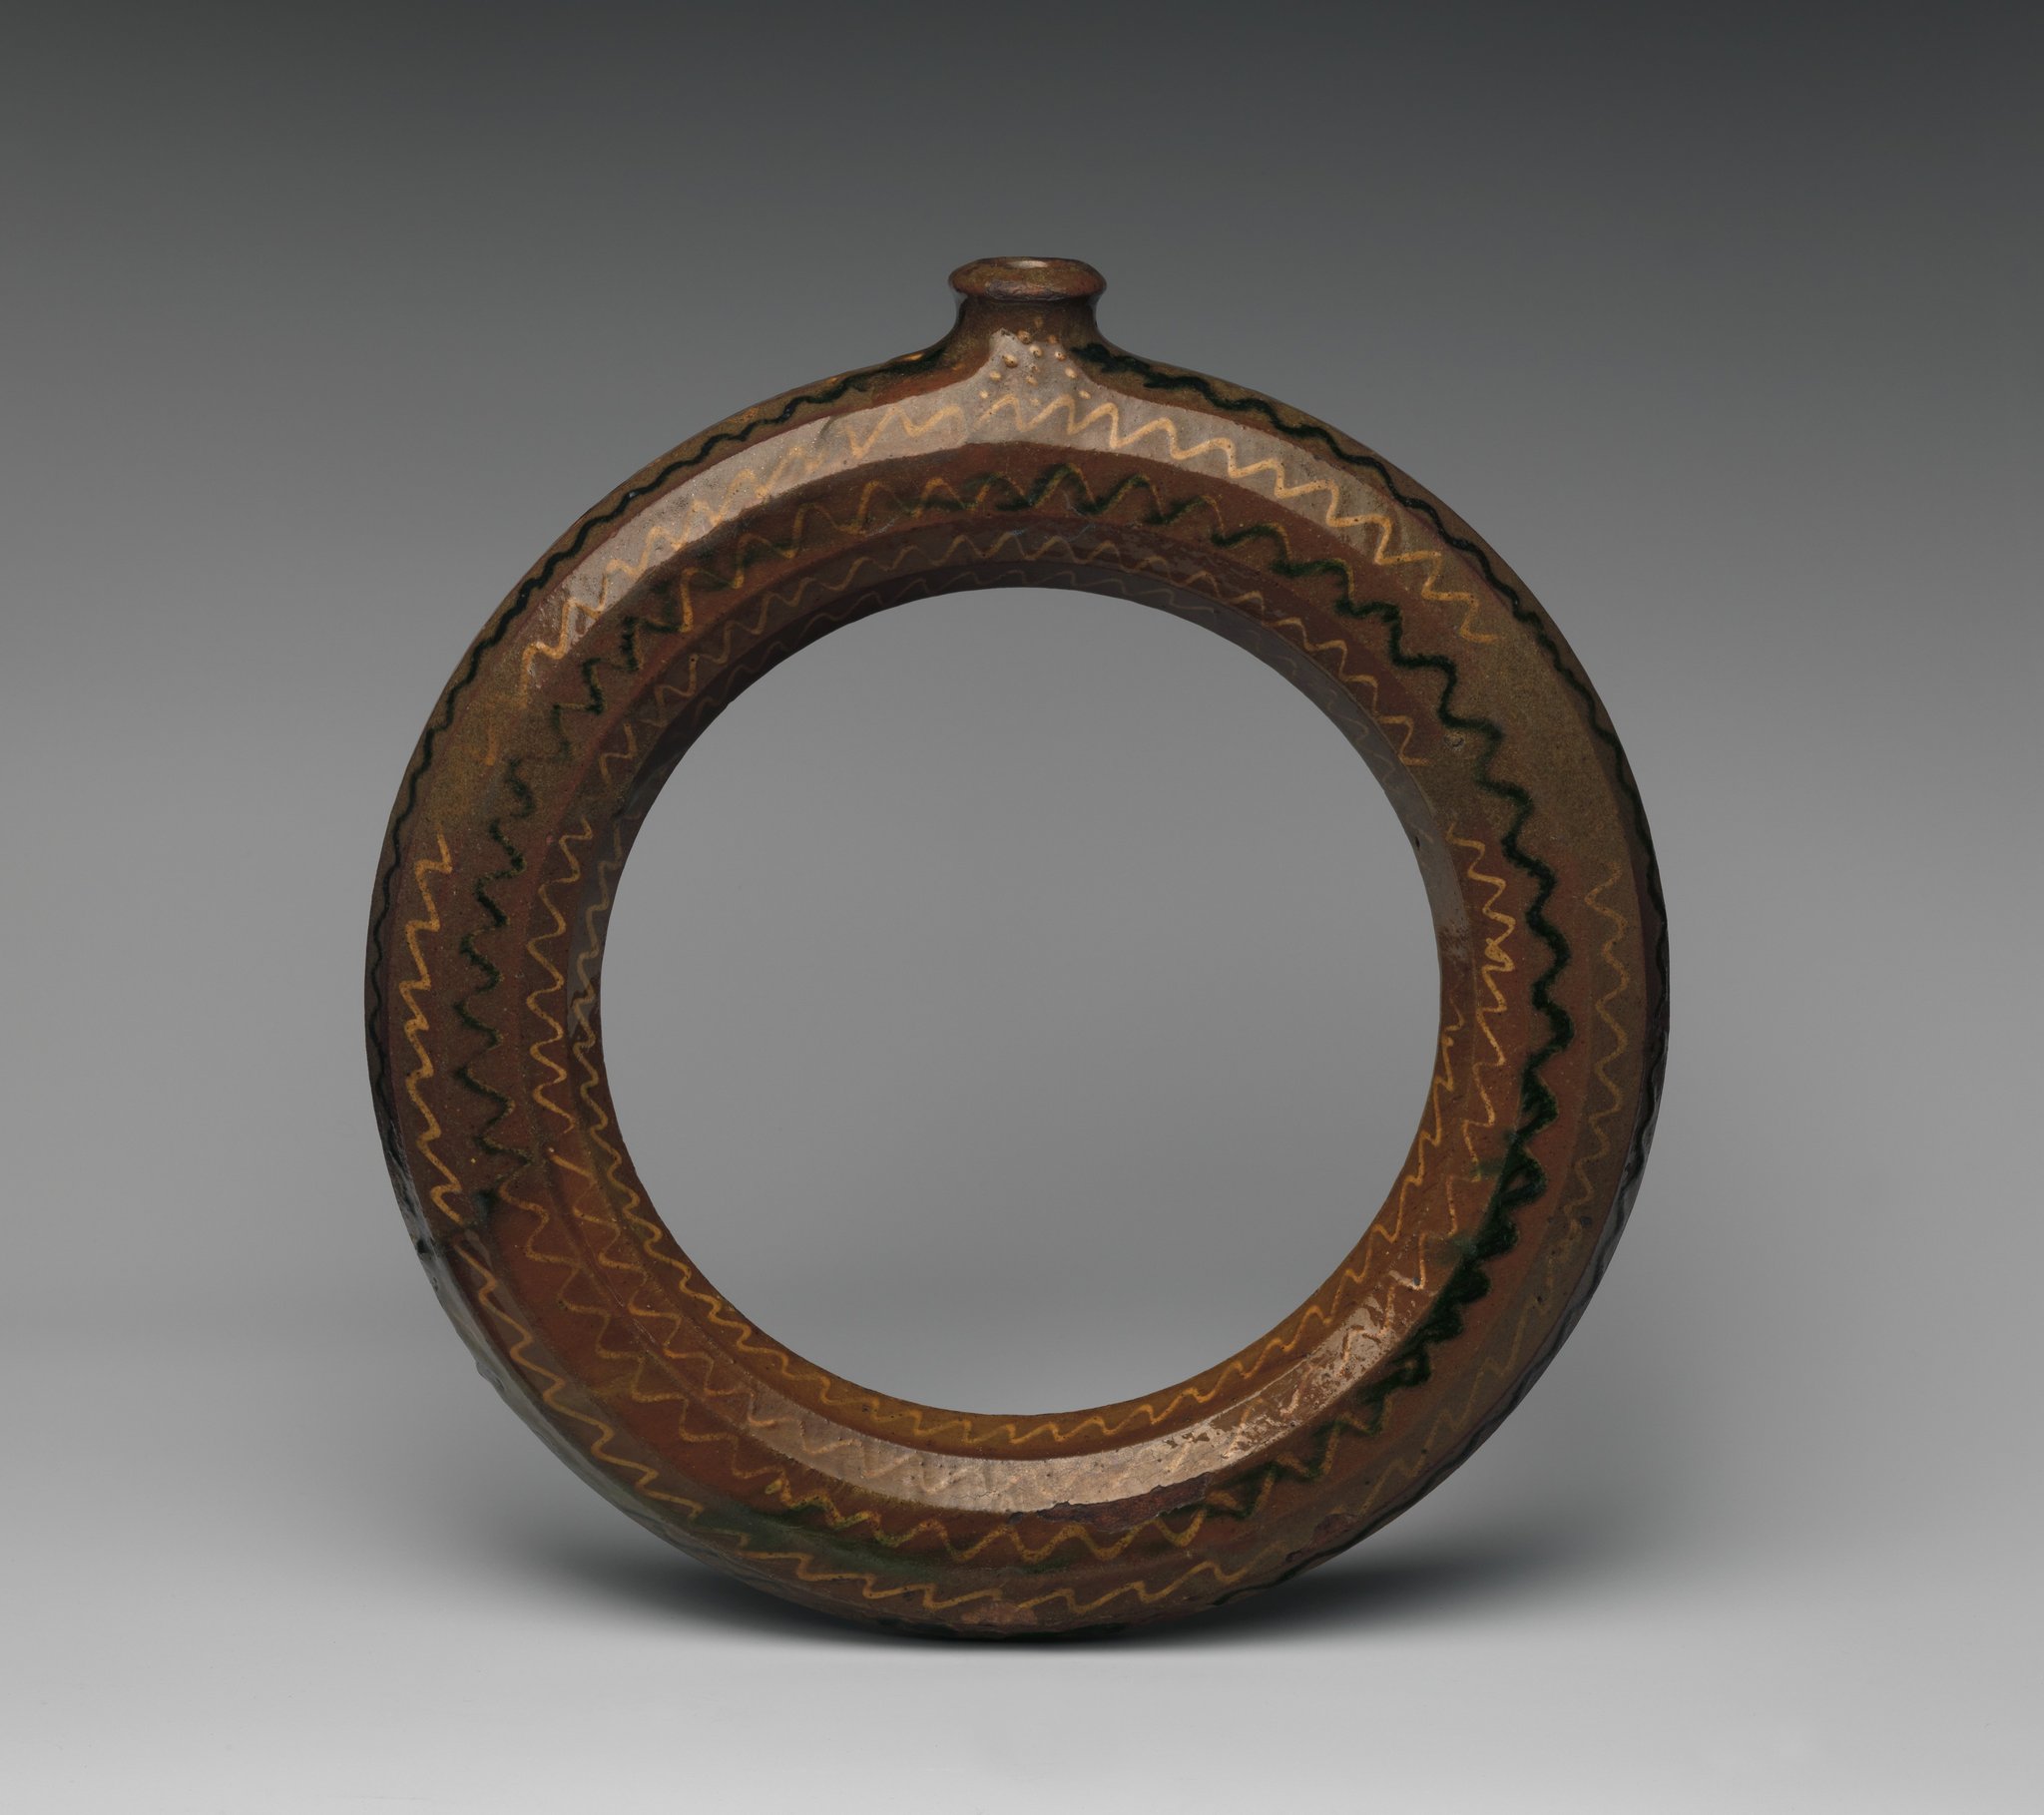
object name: bottle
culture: american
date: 1800-1900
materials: earthenware